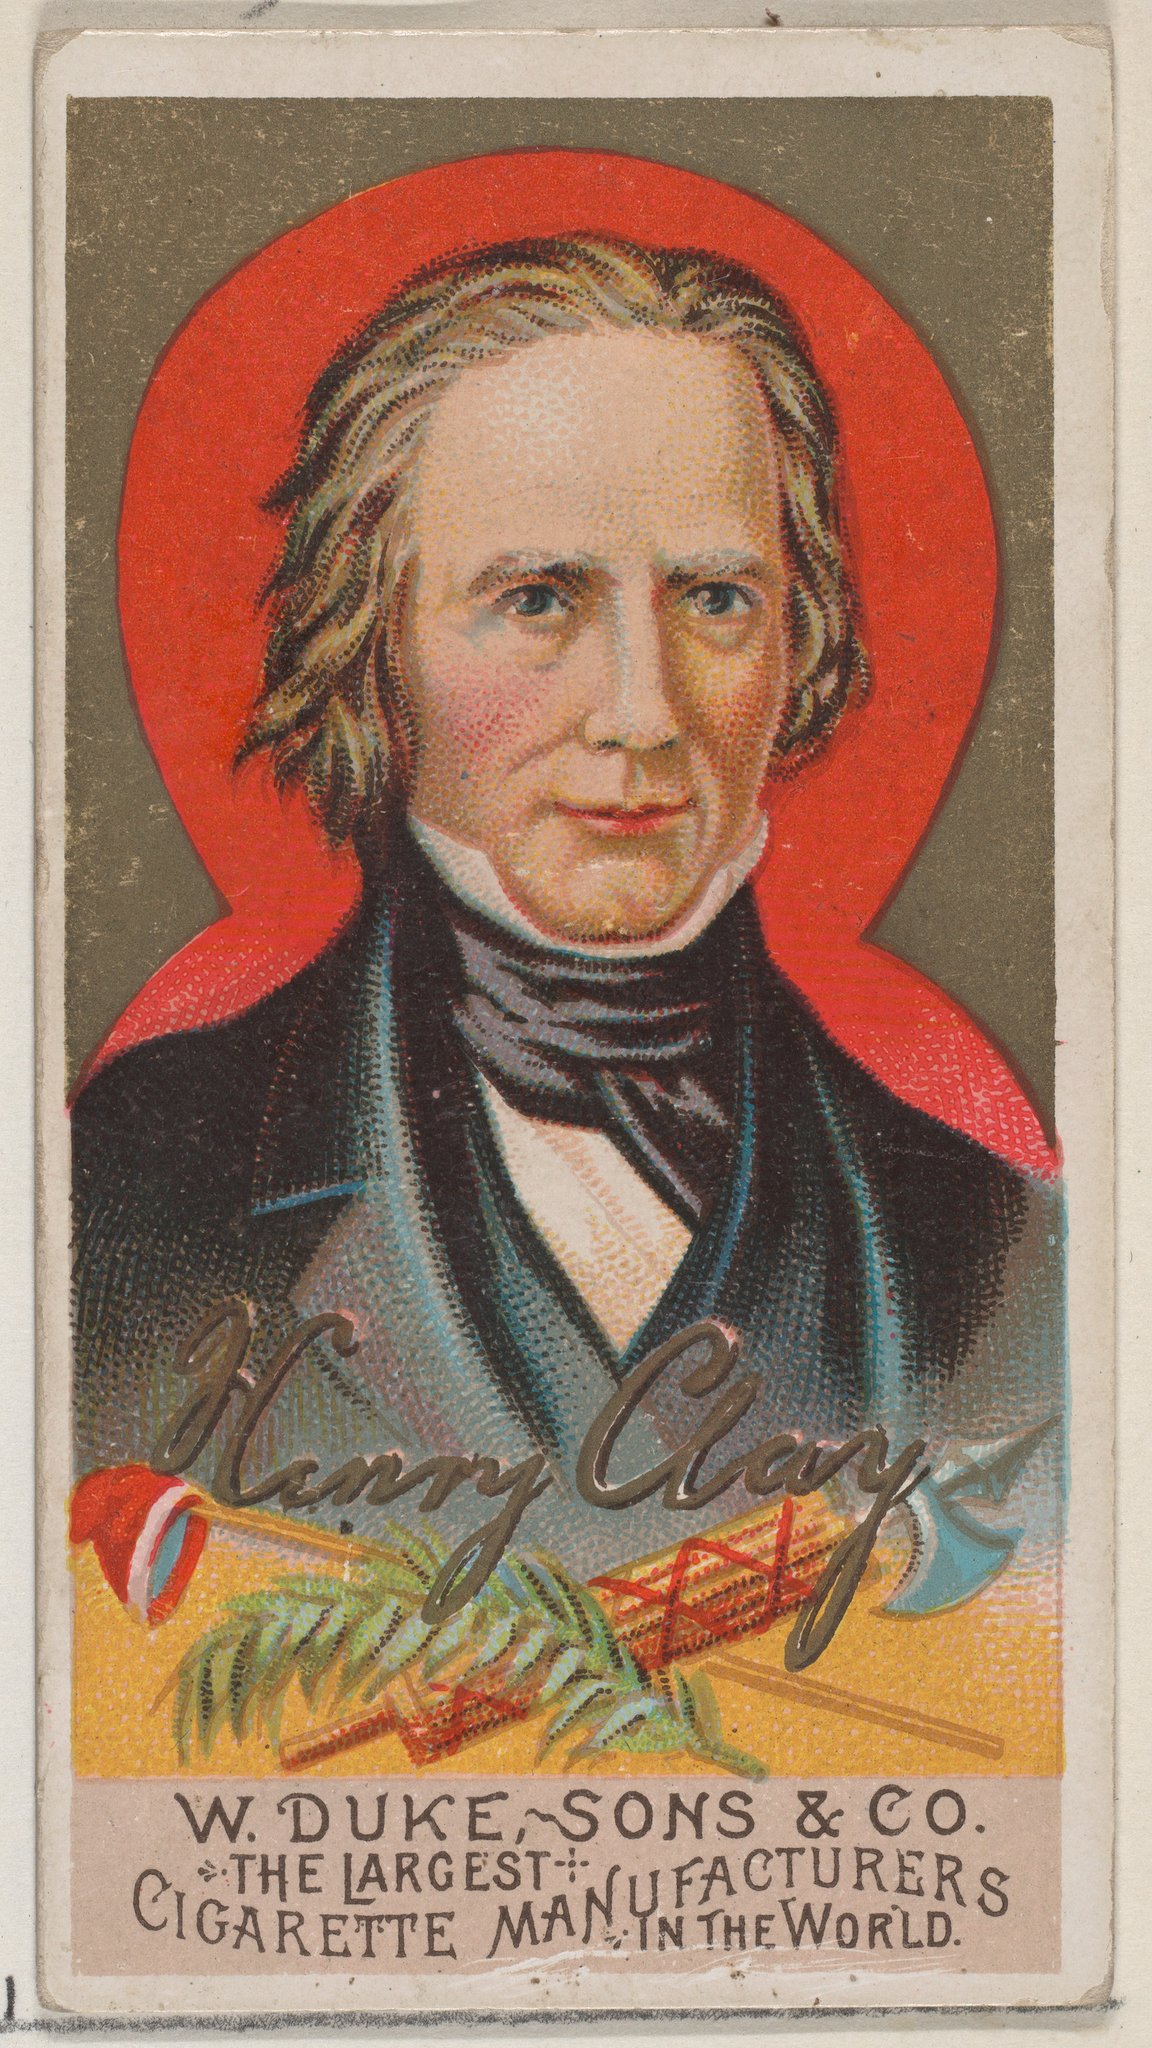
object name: print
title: Henry Clay, from the series Great Americans (N76) for Duke brand cigarettes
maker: w. duke, sons & co.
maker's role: publisher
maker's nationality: american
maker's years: 1870-1920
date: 1888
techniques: color lithograph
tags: men